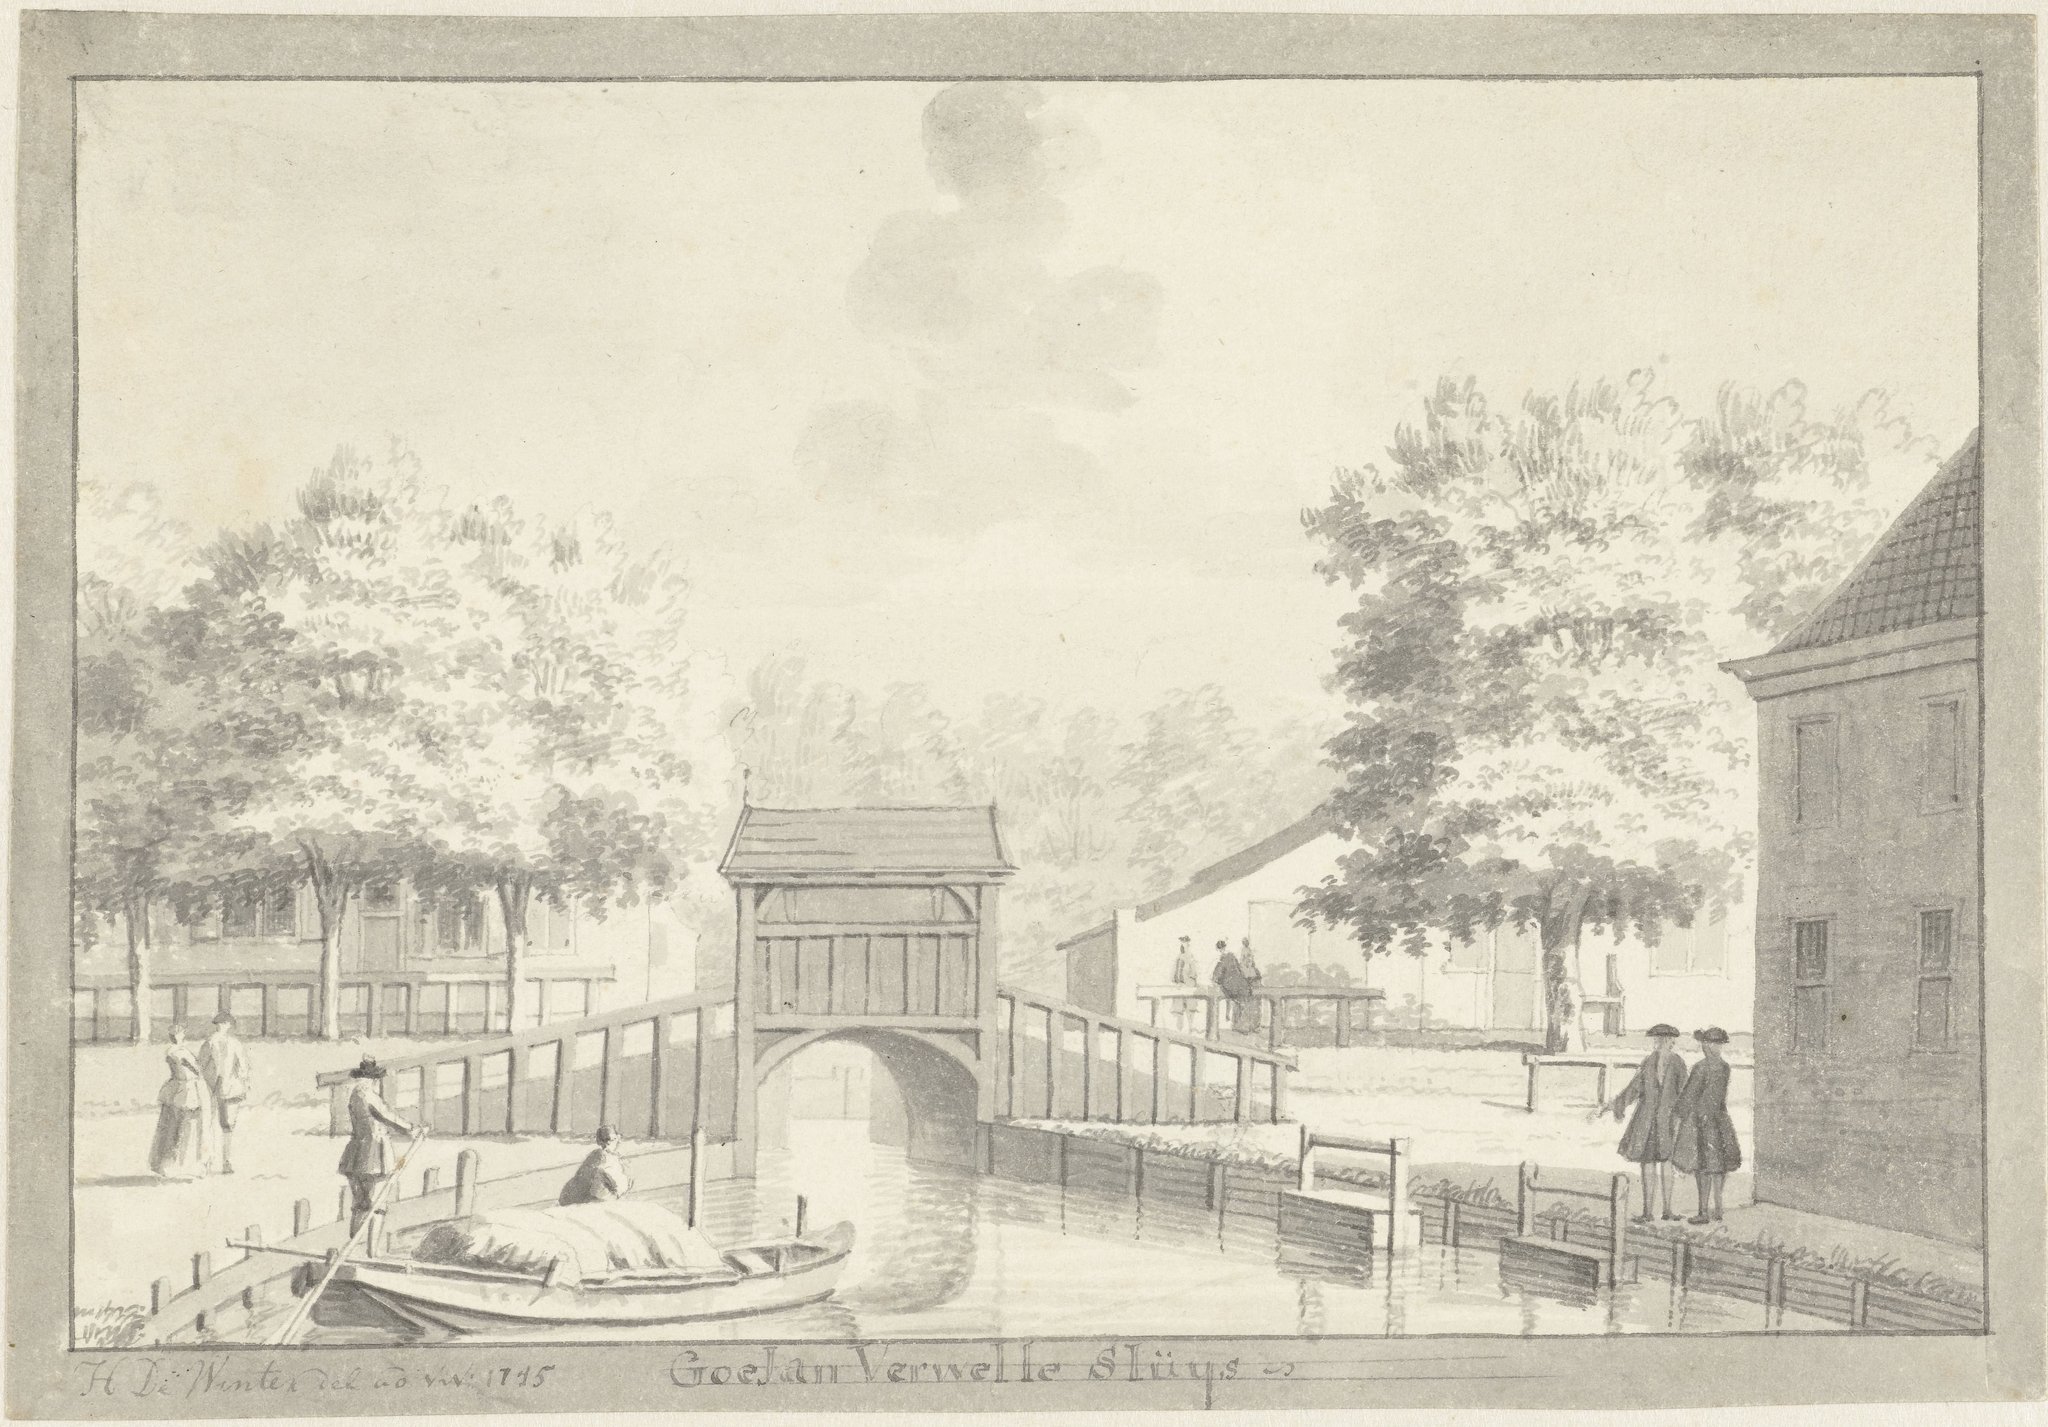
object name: drawing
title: Goejanverwellesluis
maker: hendrik de winter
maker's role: draughtsman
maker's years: 1717-1790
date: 1745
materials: ink, paper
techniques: brush, pen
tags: sluice, weir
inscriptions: inscription: ‘H De Winter del ad viv: 1745 GoeJan Verwelle Sluys’